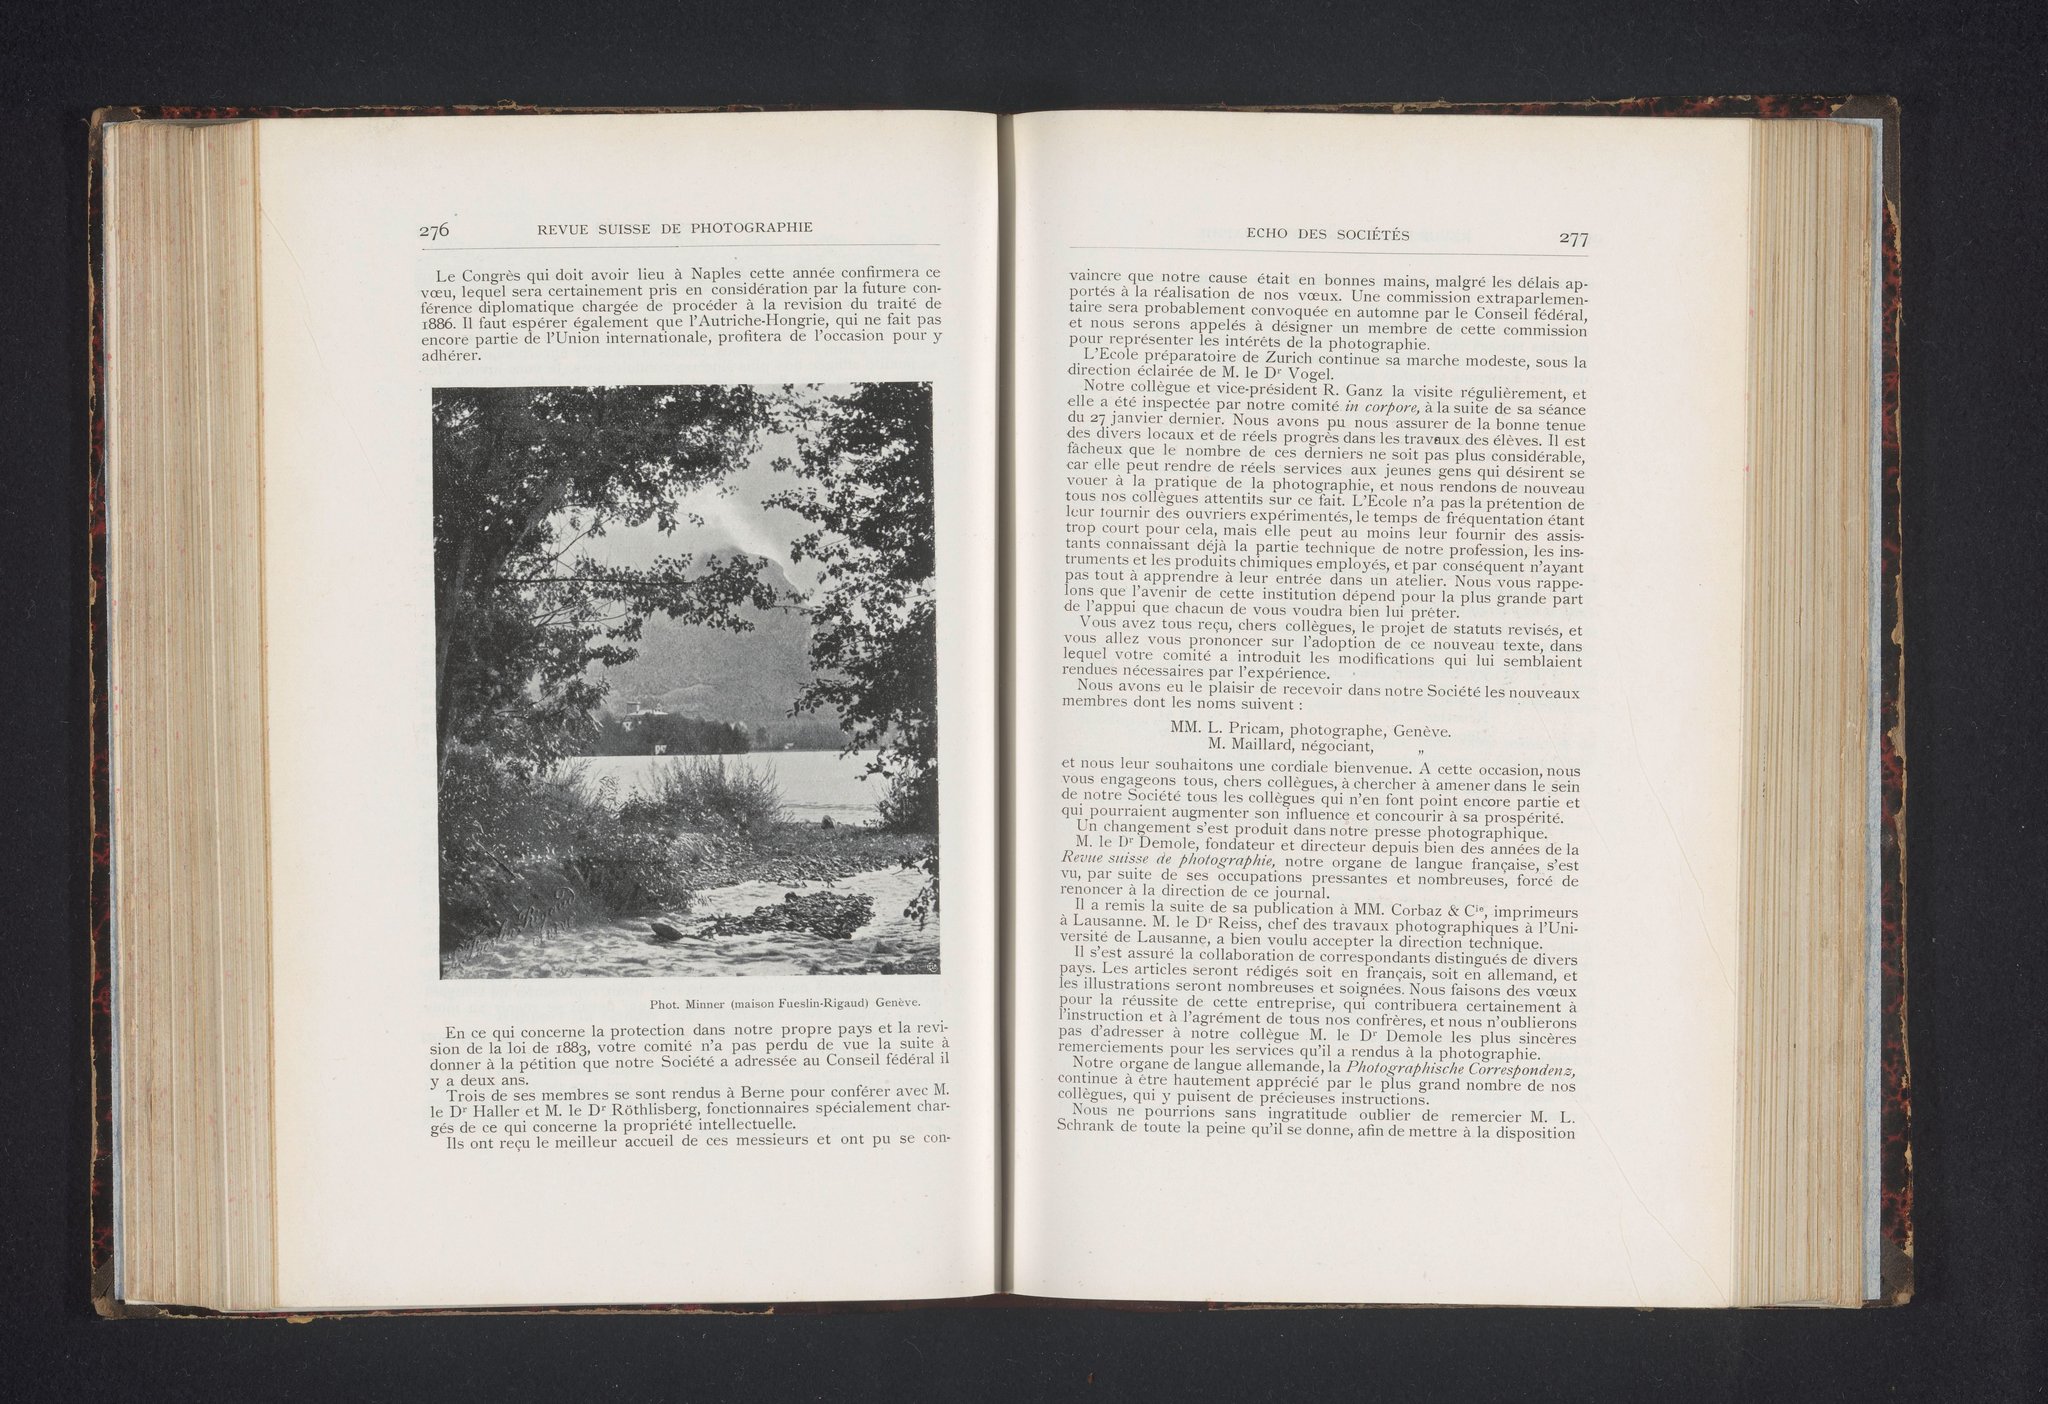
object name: page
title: Gezicht op een meer tussen de bergen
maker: Anonymous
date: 1897-1902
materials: paper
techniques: autotype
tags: lake, mountains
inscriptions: inscription: ‘Phot. Minner (Maison Fueslin-Rigaud) Genève’, monogram: ‘C. Cie’